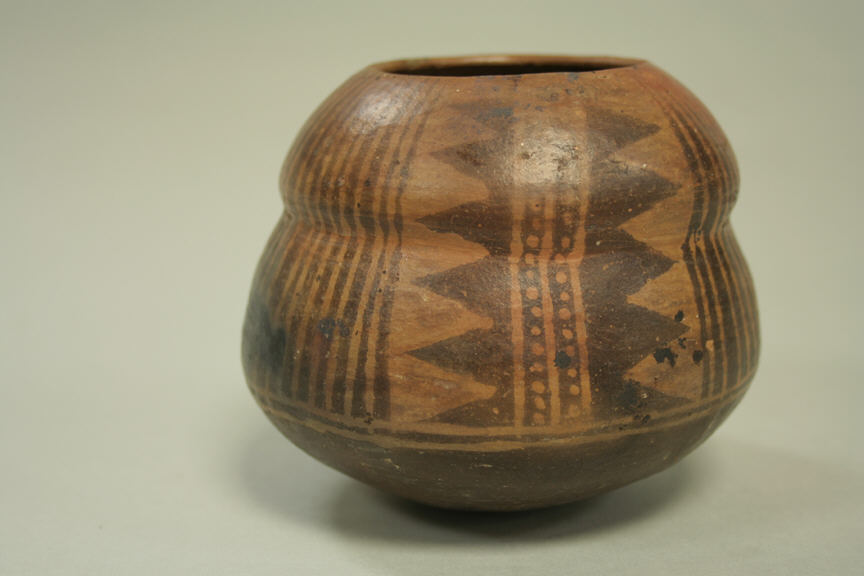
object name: bowl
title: Double-Lobed Bowl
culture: paracas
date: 200-1 BCE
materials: ceramic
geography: peru